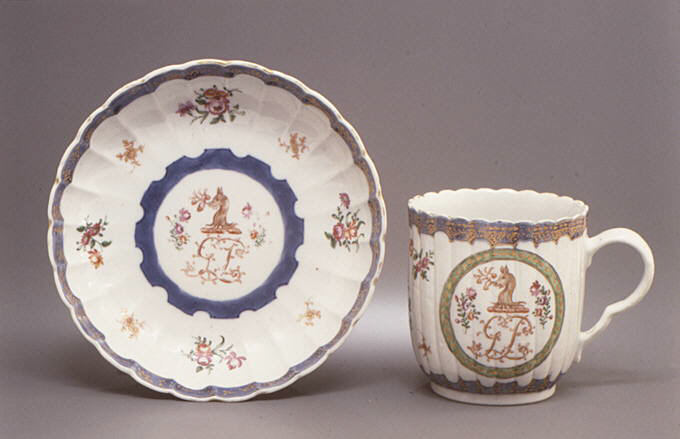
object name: cup and saucer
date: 1785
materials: hard paste porcelain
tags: flowers,insignia